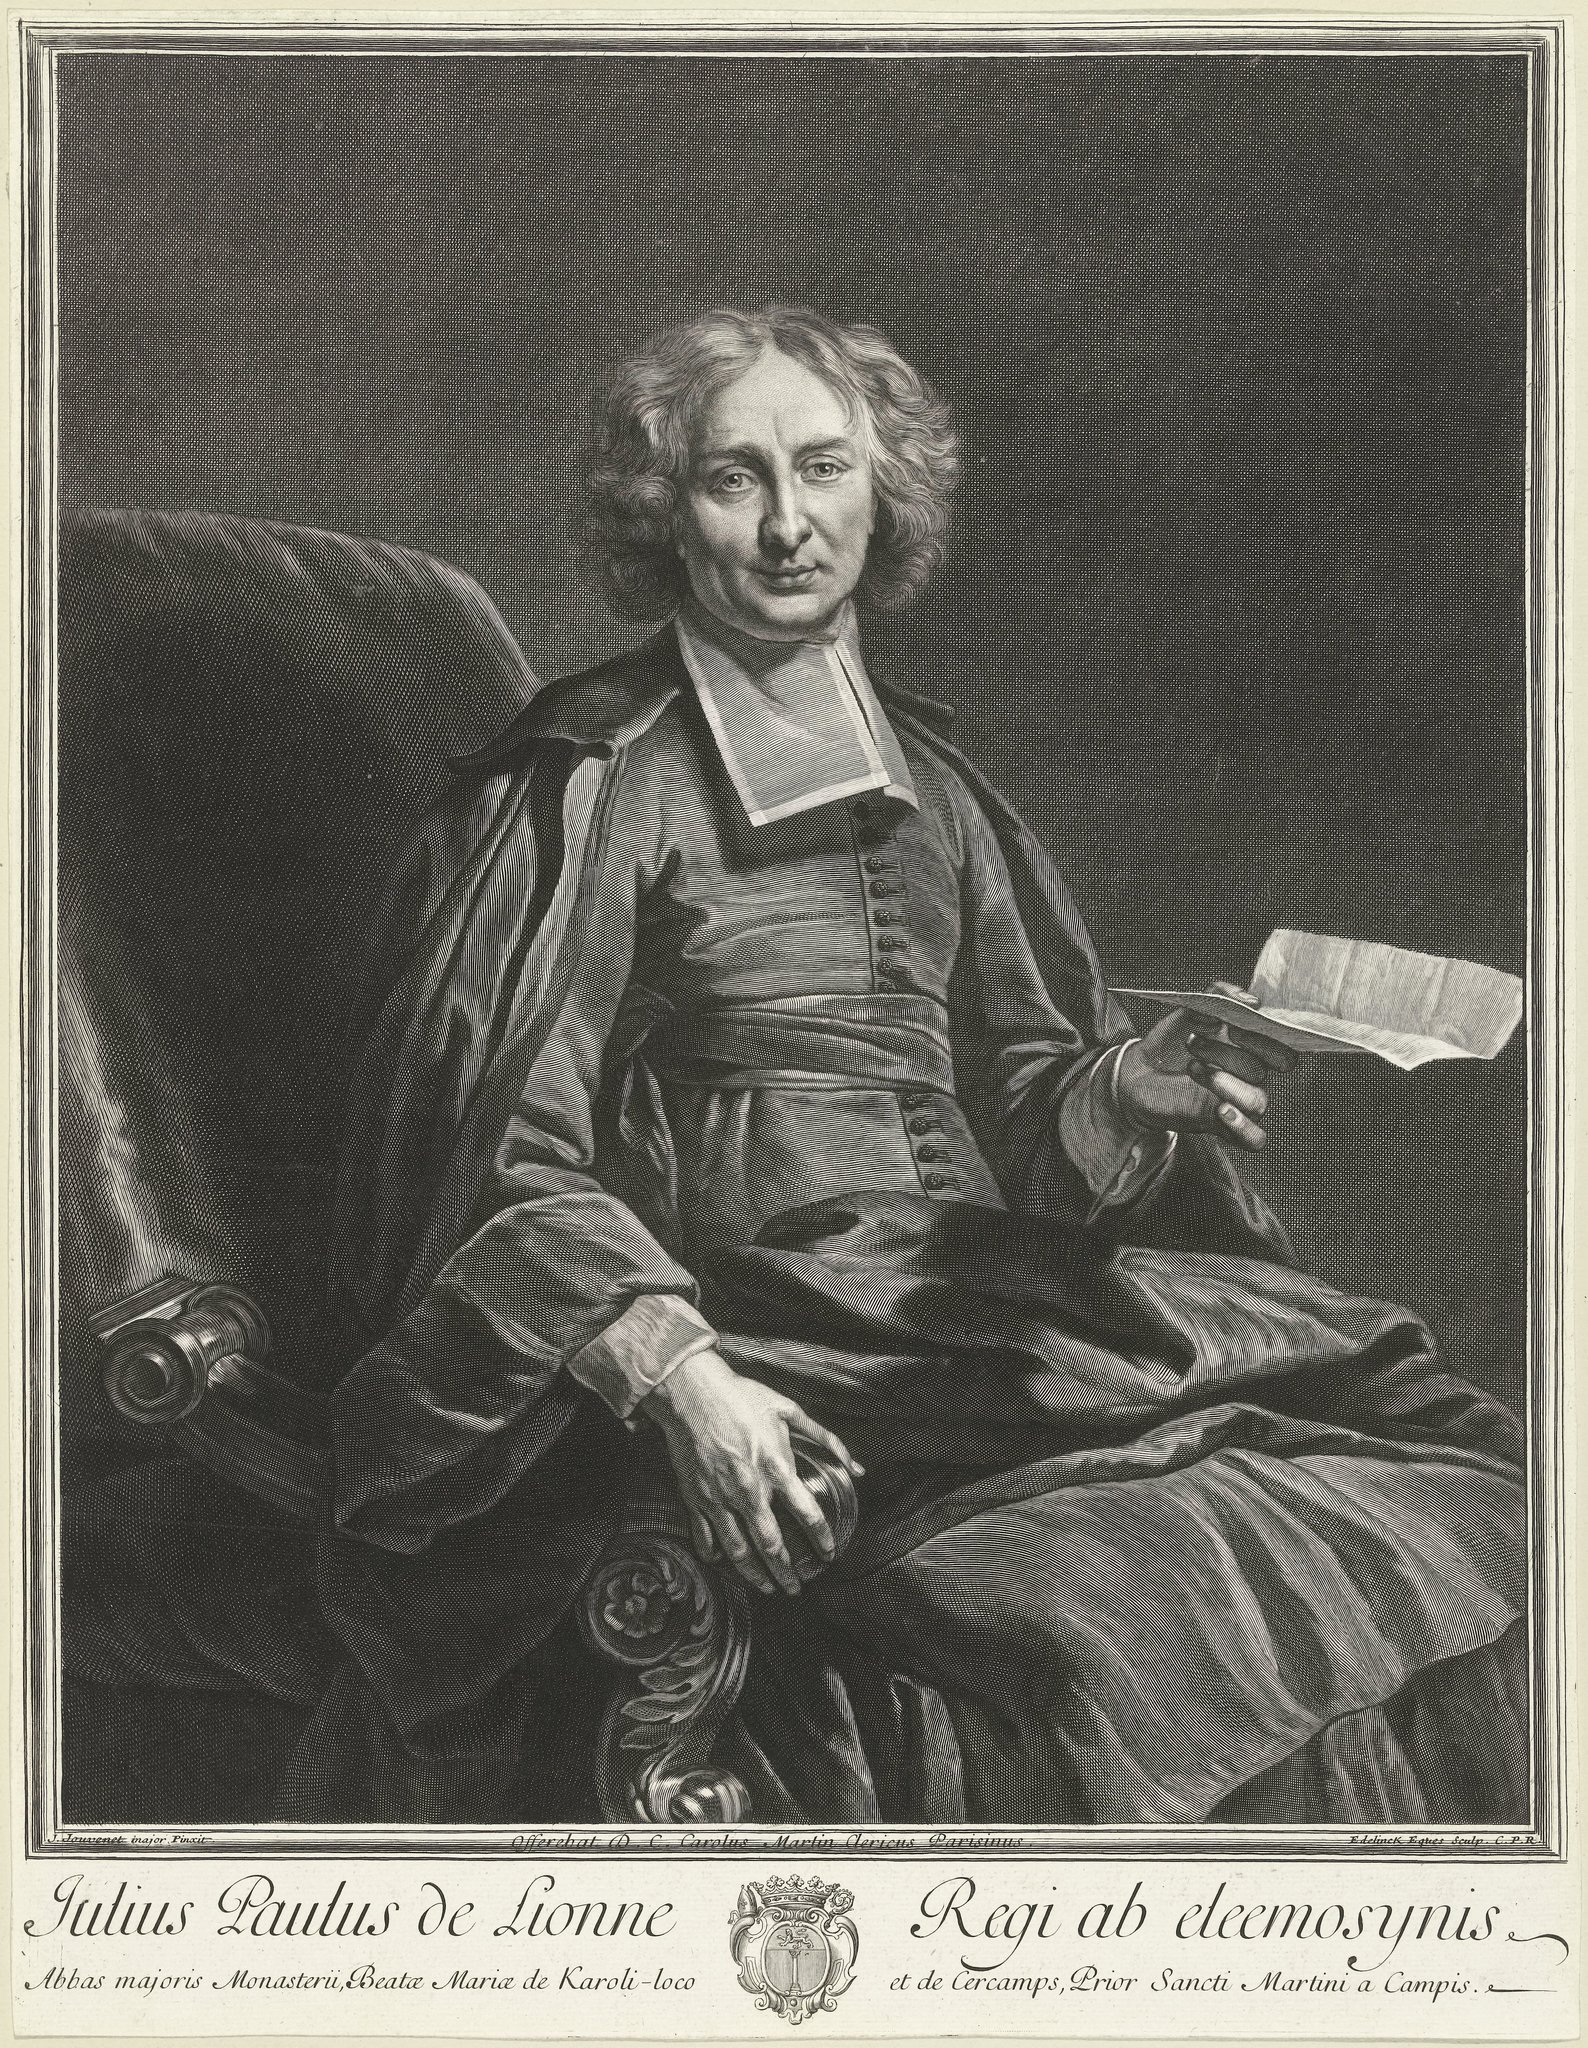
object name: print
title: Portret van Jules-Paul de Lionne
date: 1666-1707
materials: paper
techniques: engraving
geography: france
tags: jules-paul de lionne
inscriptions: collector's mark: Lugt 240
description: Portret van Jules-Paul de Lionne (1644-1721), aalmoezenier aan het hof van Lodewijk XIV, zittend afgebeeld met in zijn linker hand een document en met rechter hand op de leuning van zijn stoel.